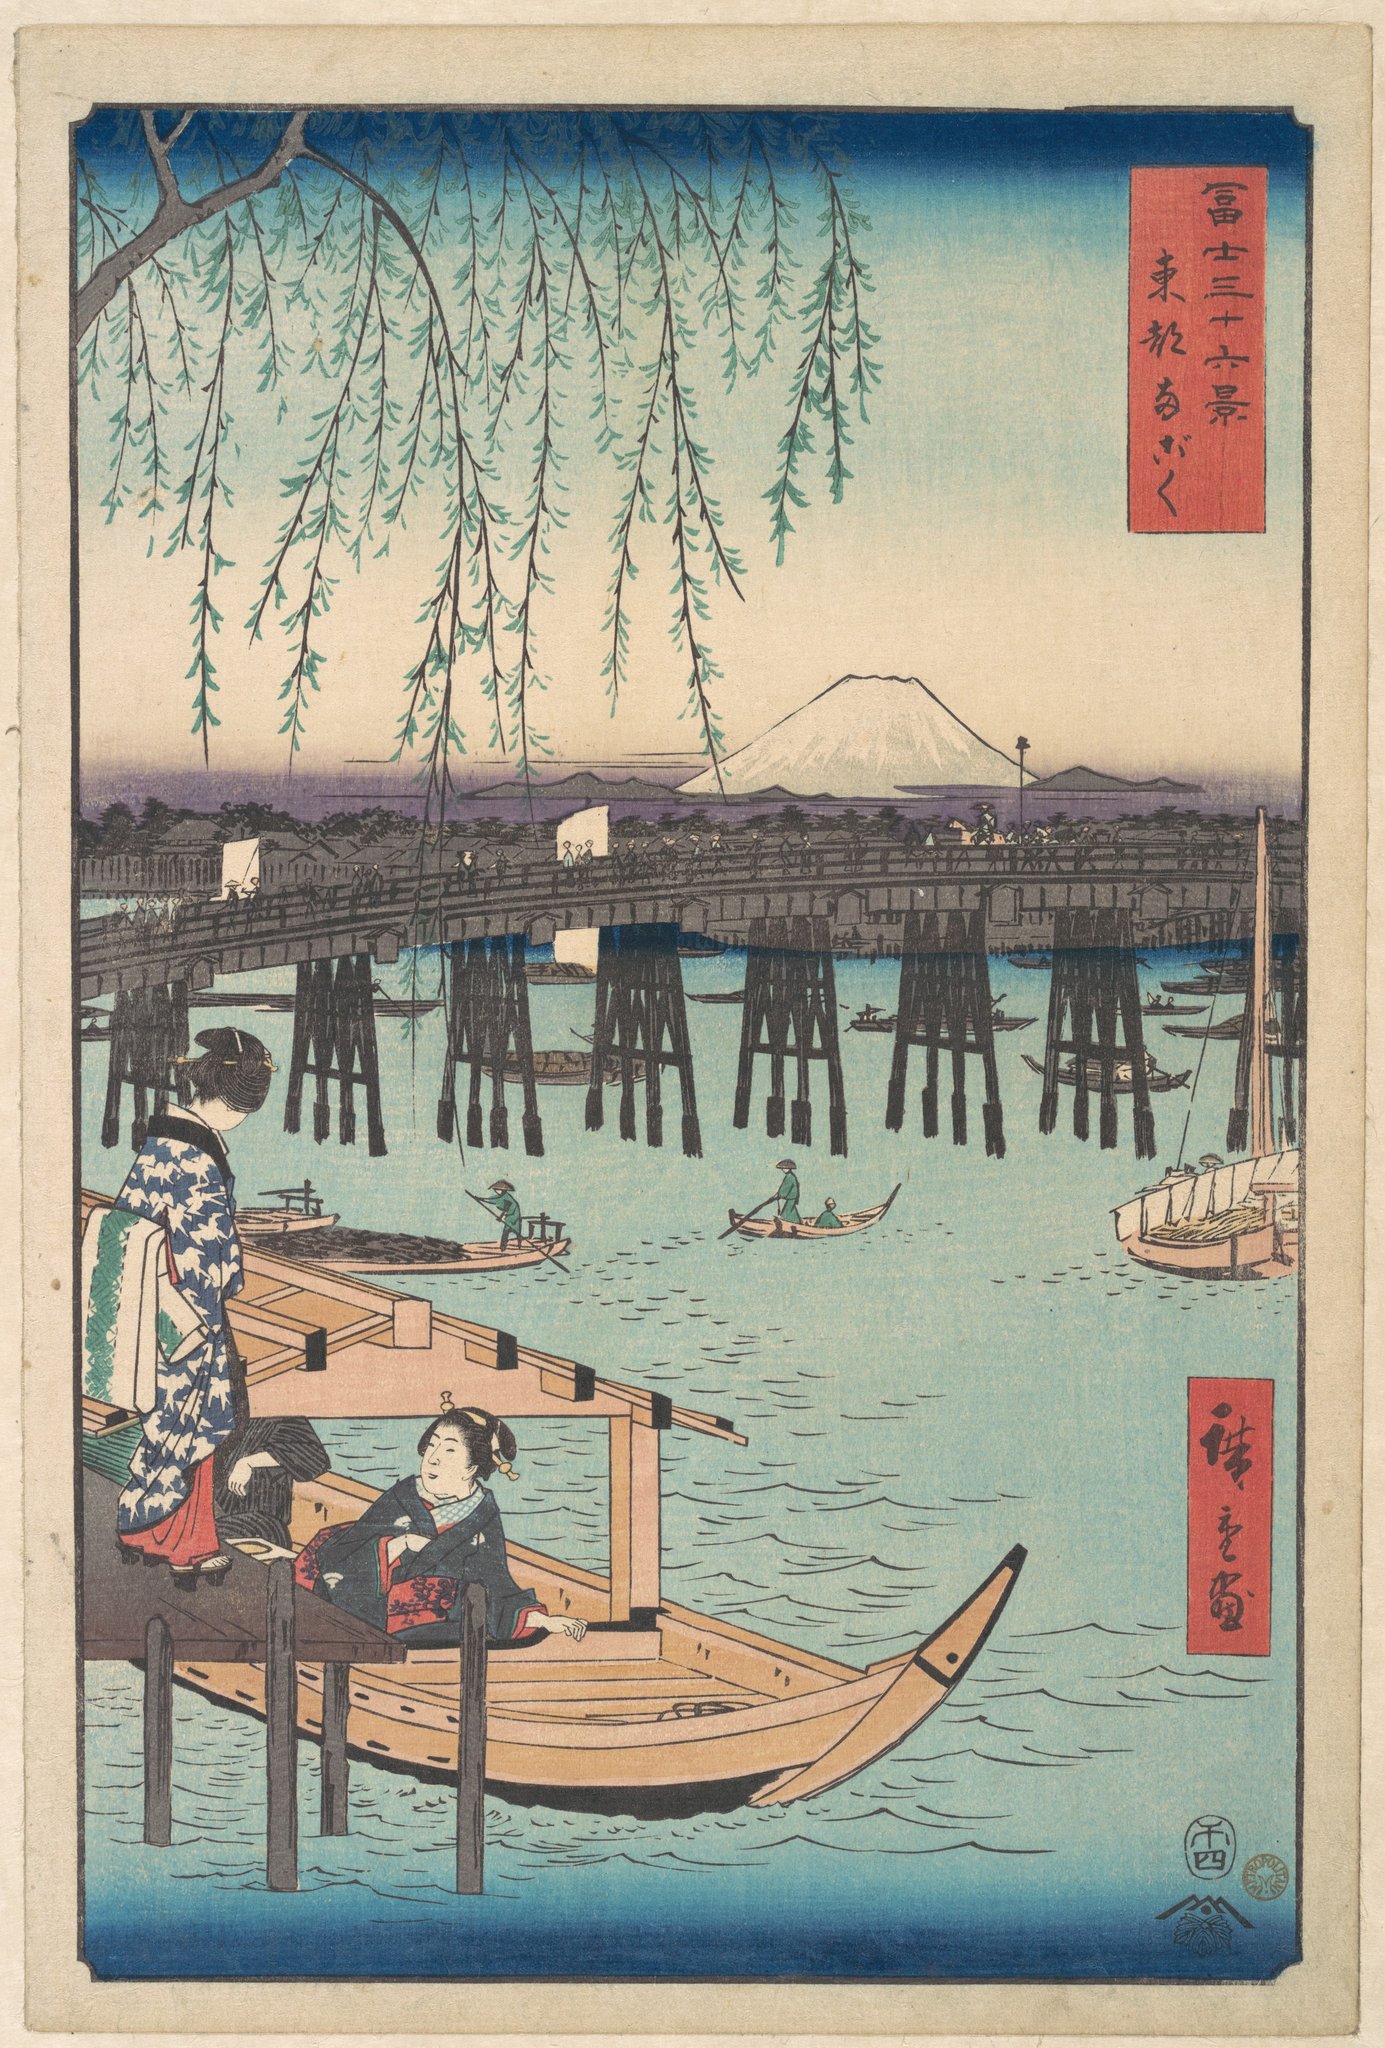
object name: print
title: Toto, Ryogoku, from the series Thirty-six Views of Mount Fuji (Fugaku sanjūrokkei)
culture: japanese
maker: utagawa hiroshige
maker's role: artist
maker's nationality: japanese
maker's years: 1797-1858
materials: ink, paper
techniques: woodblock print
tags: bridges,women,mountains,boats